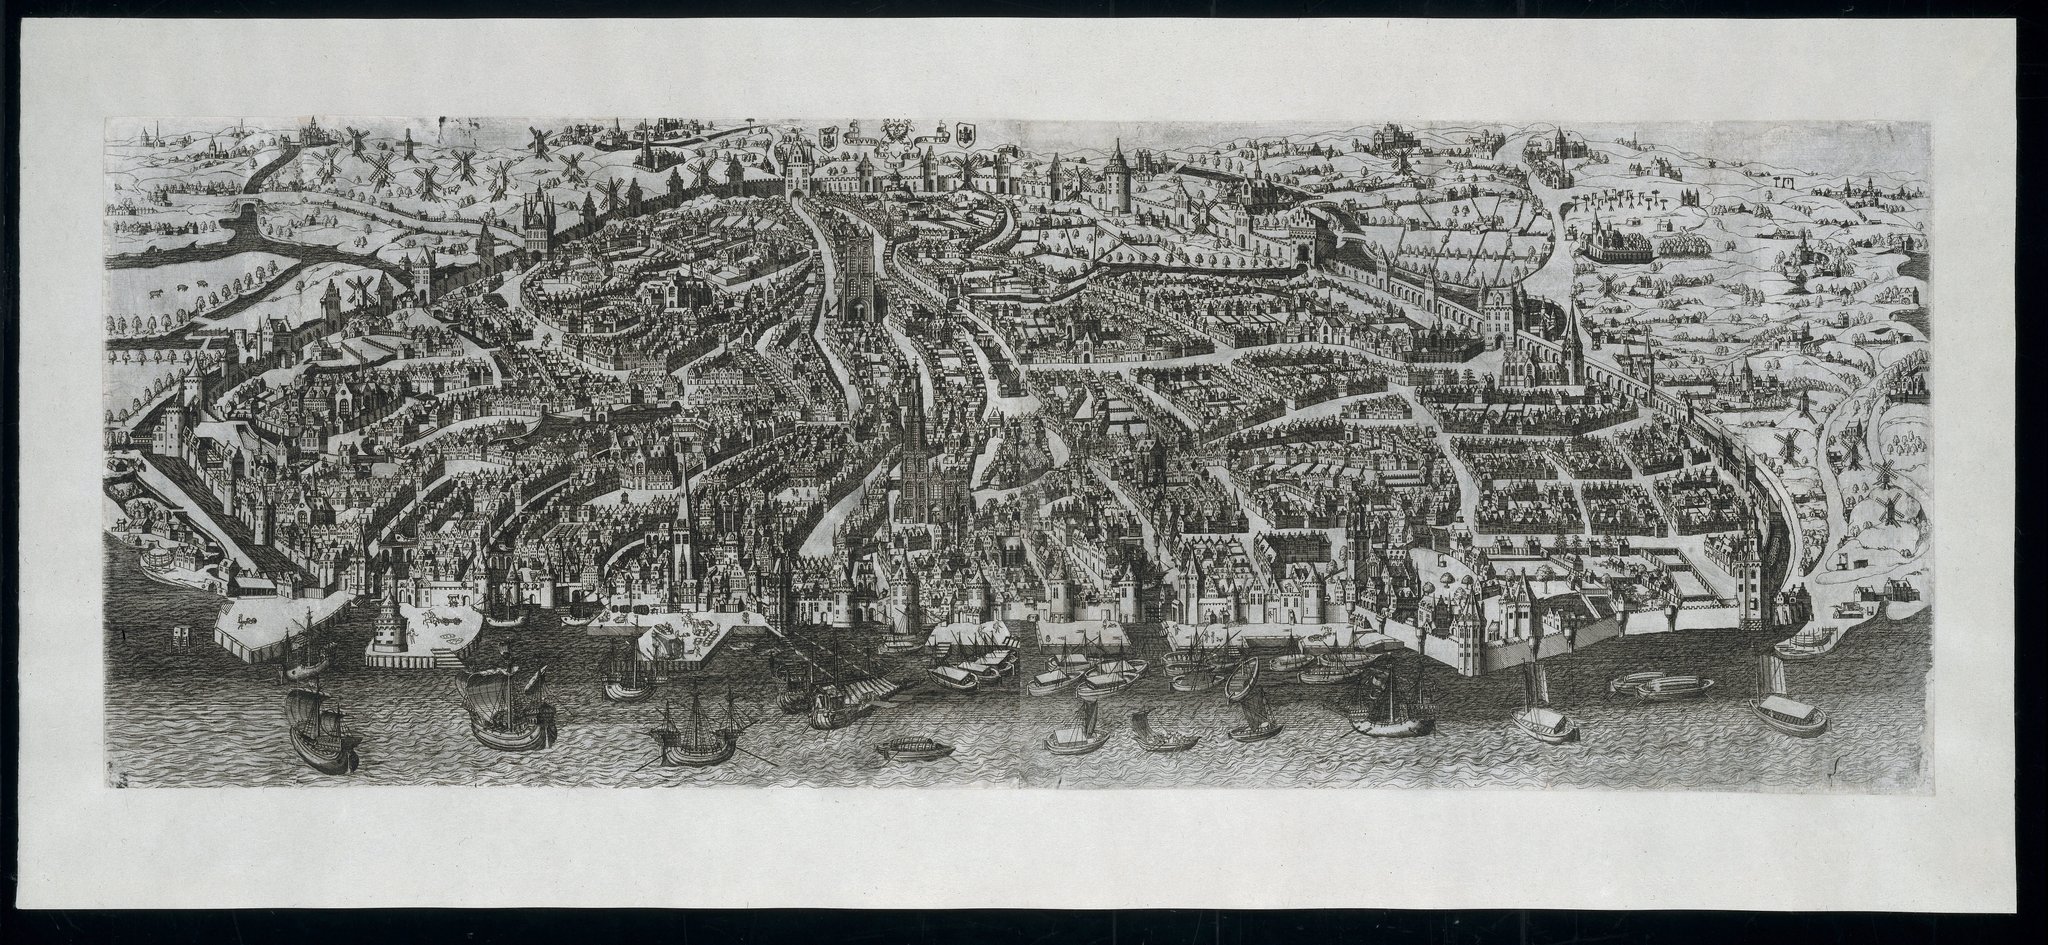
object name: print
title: Gezicht op Antwerpen, in vogelvlucht perspectief, vanuit het westen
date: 1524-1528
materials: paper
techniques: engraving, etching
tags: maps of cities, antwerp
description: Gezicht op Antwerpen, in vogelvlucht perspectief, vanuit het westen, ca. 1524-1528.